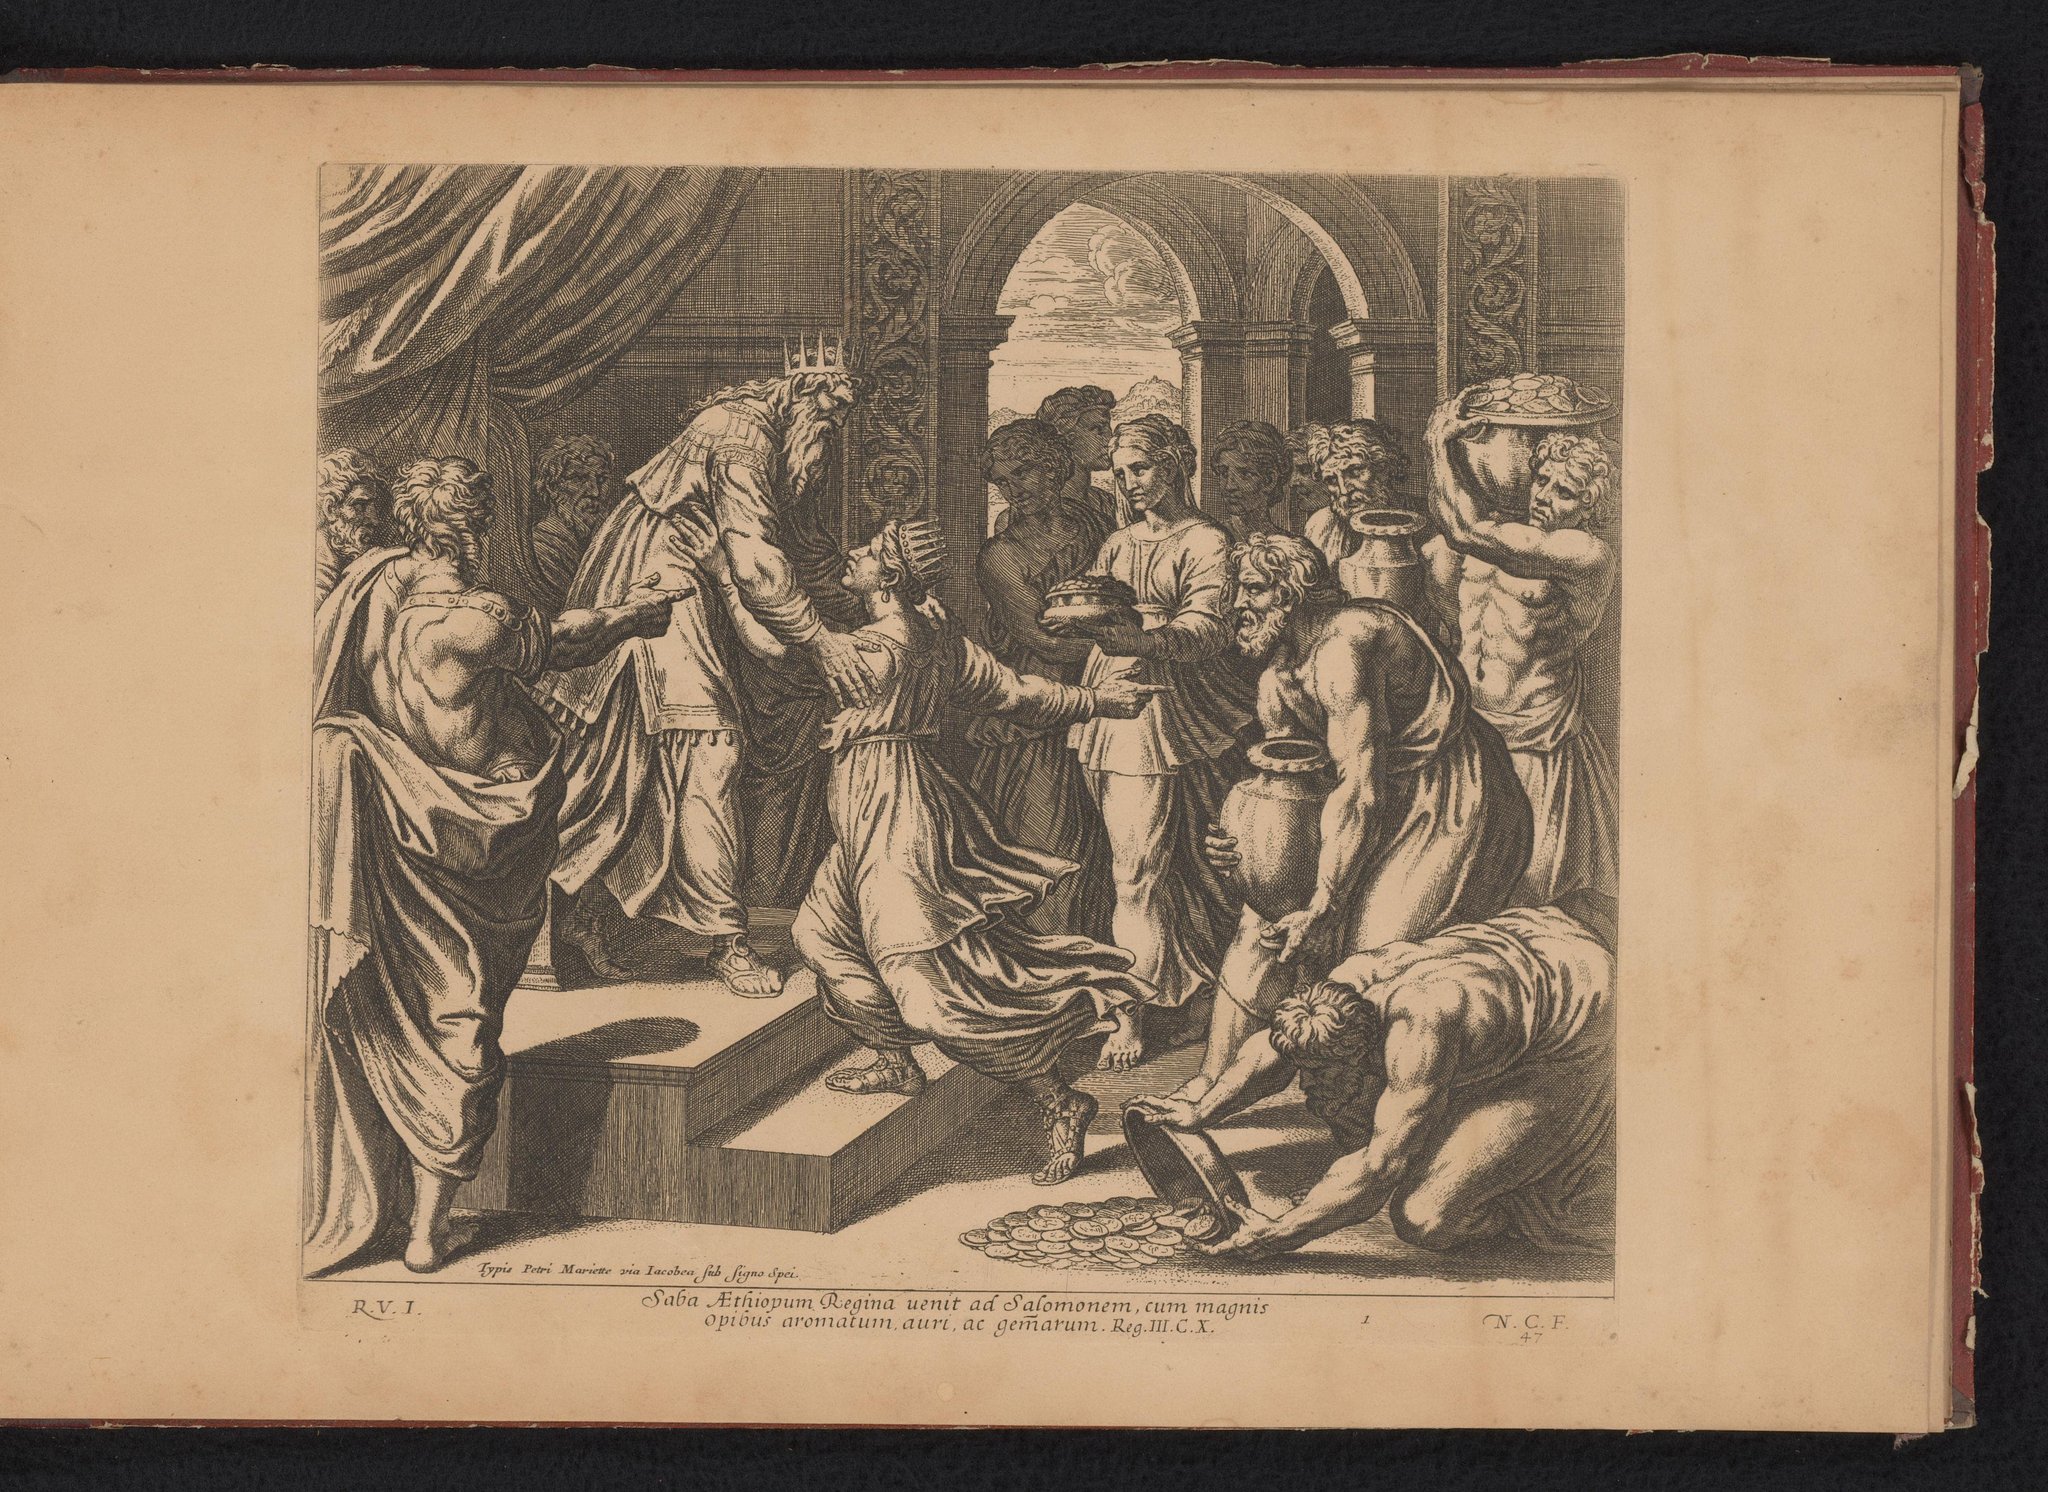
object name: print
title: Rafaël Bijbel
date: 1649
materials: paper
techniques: etching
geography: paris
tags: solomon and the queen of sheba (1 kings 10:1-3; 2 chronicles 9:1-9), homage to solomon: the queen of sheba gives solomon gold, precious stones and spices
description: Deze prent maakt deel uit van een album.